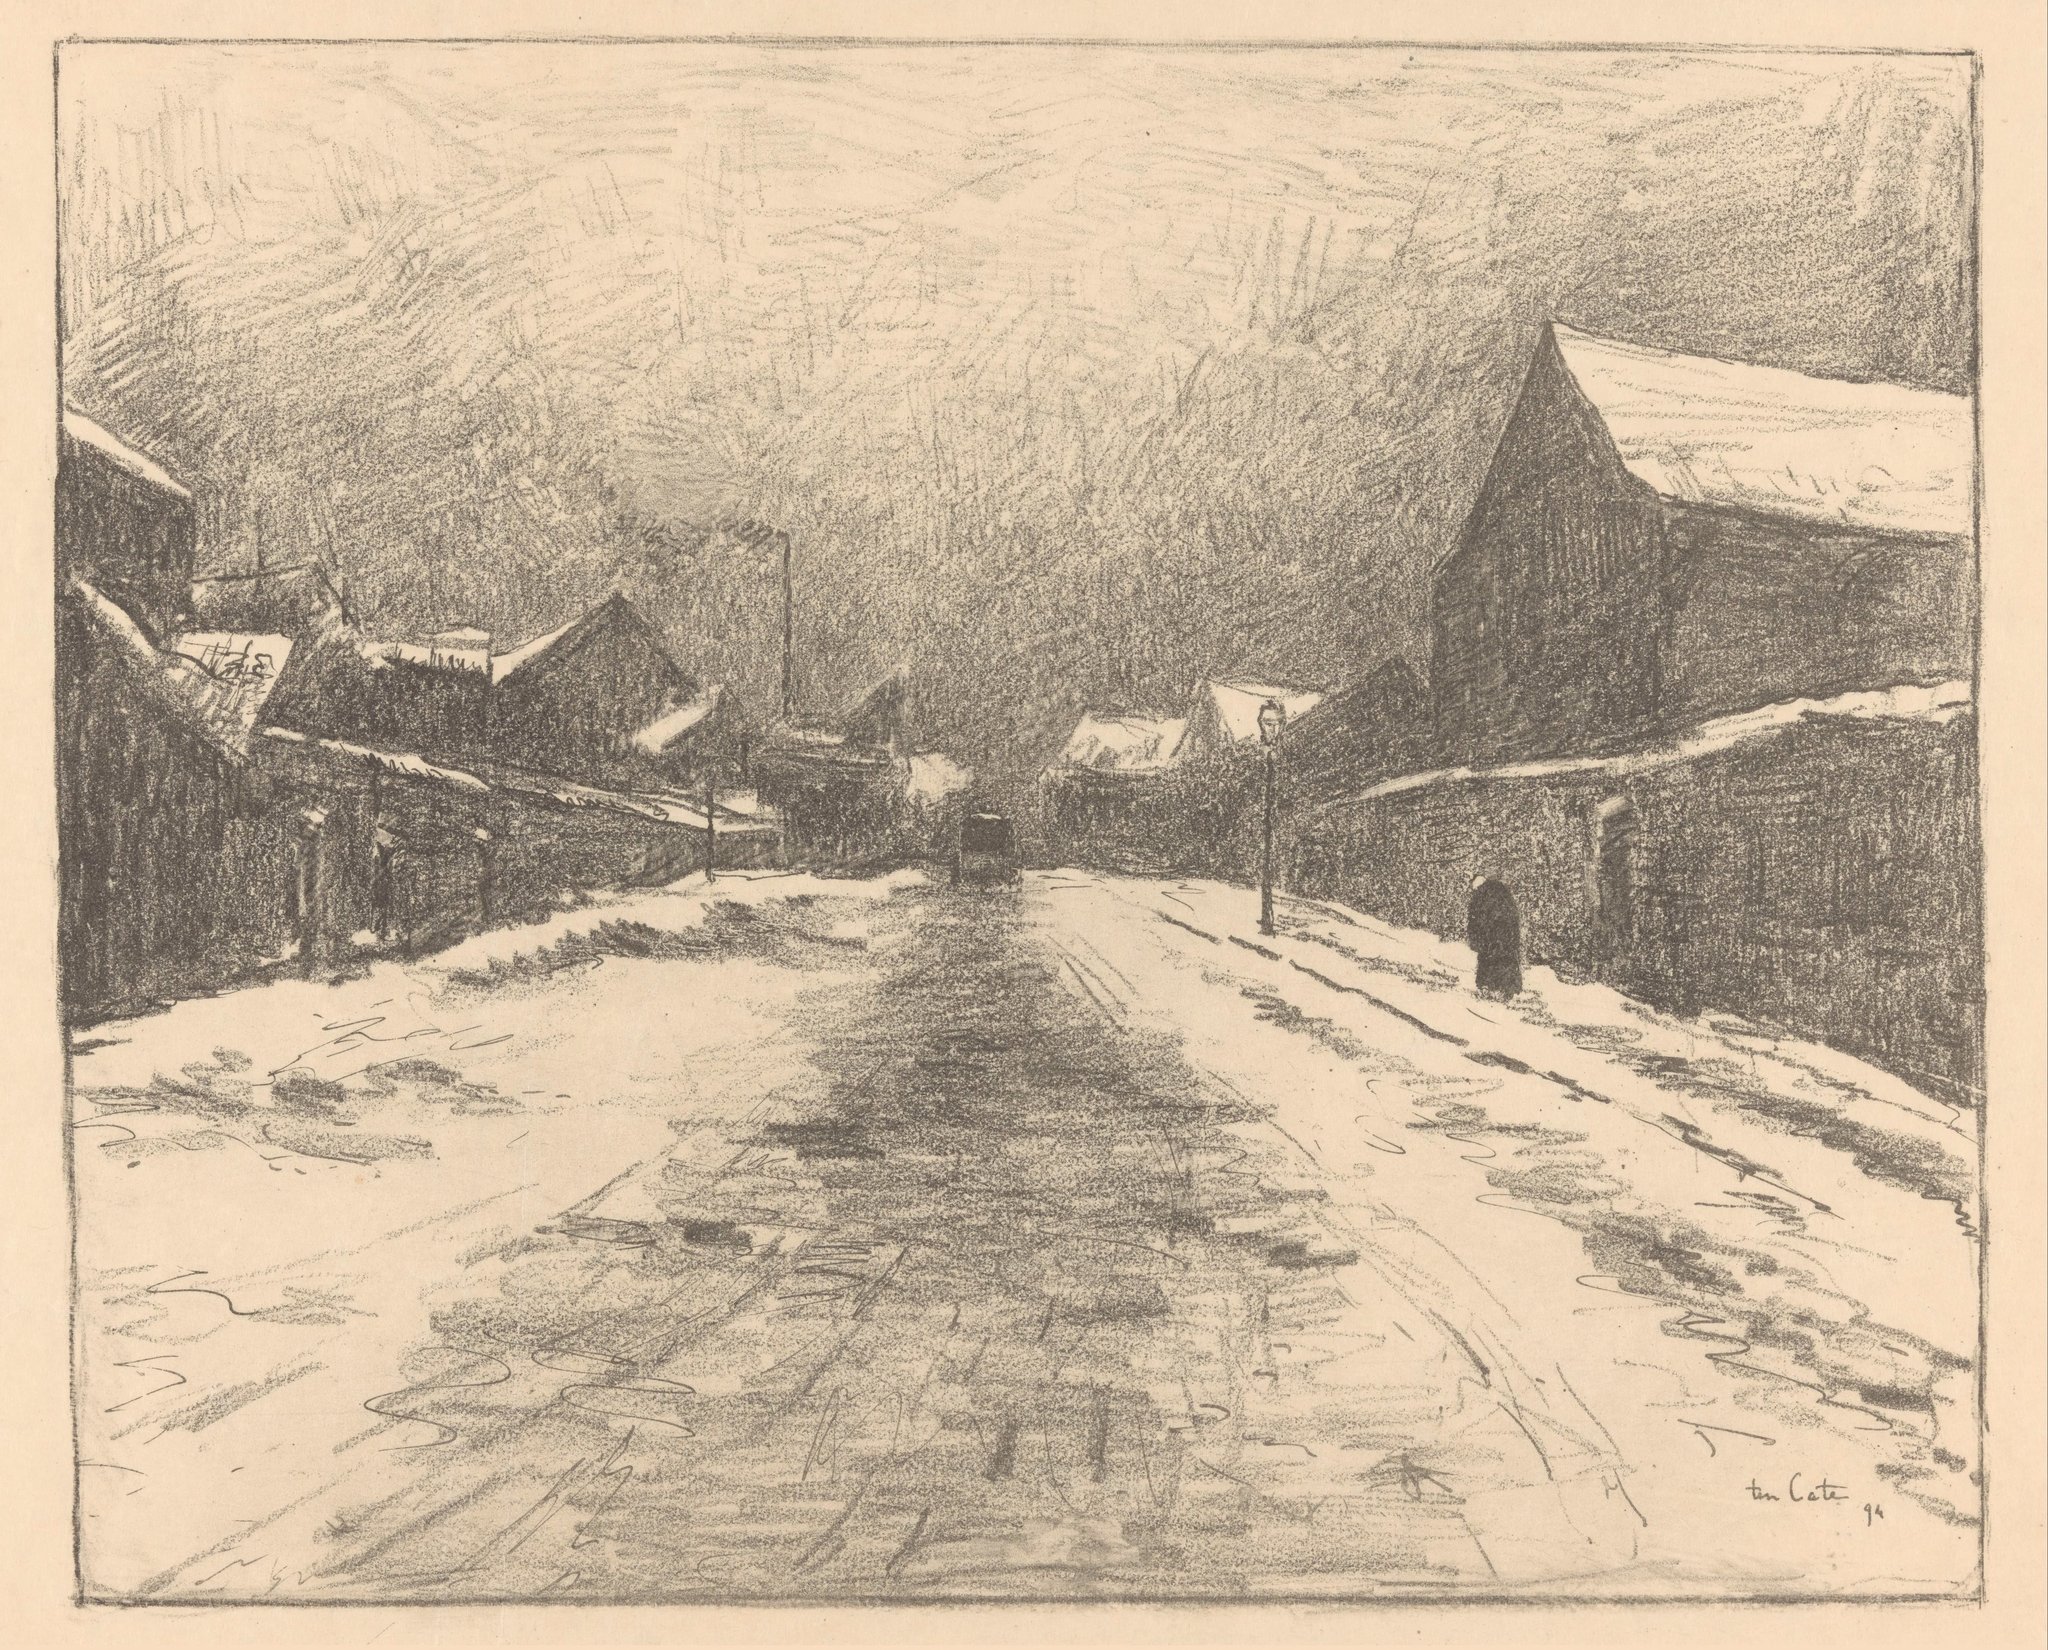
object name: print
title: La Rue d'Alsace, (te Penit près Bienne?)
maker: siebe johannes ten cate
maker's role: draughtsman, print maker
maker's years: 1858-1908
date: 1894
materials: paper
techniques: lithograph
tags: snow, street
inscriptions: collector's mark: Lugt 2228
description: Een wandelende figuur op een met sneeuw bedekte straat. Links en rechts huizen met puntdaken.